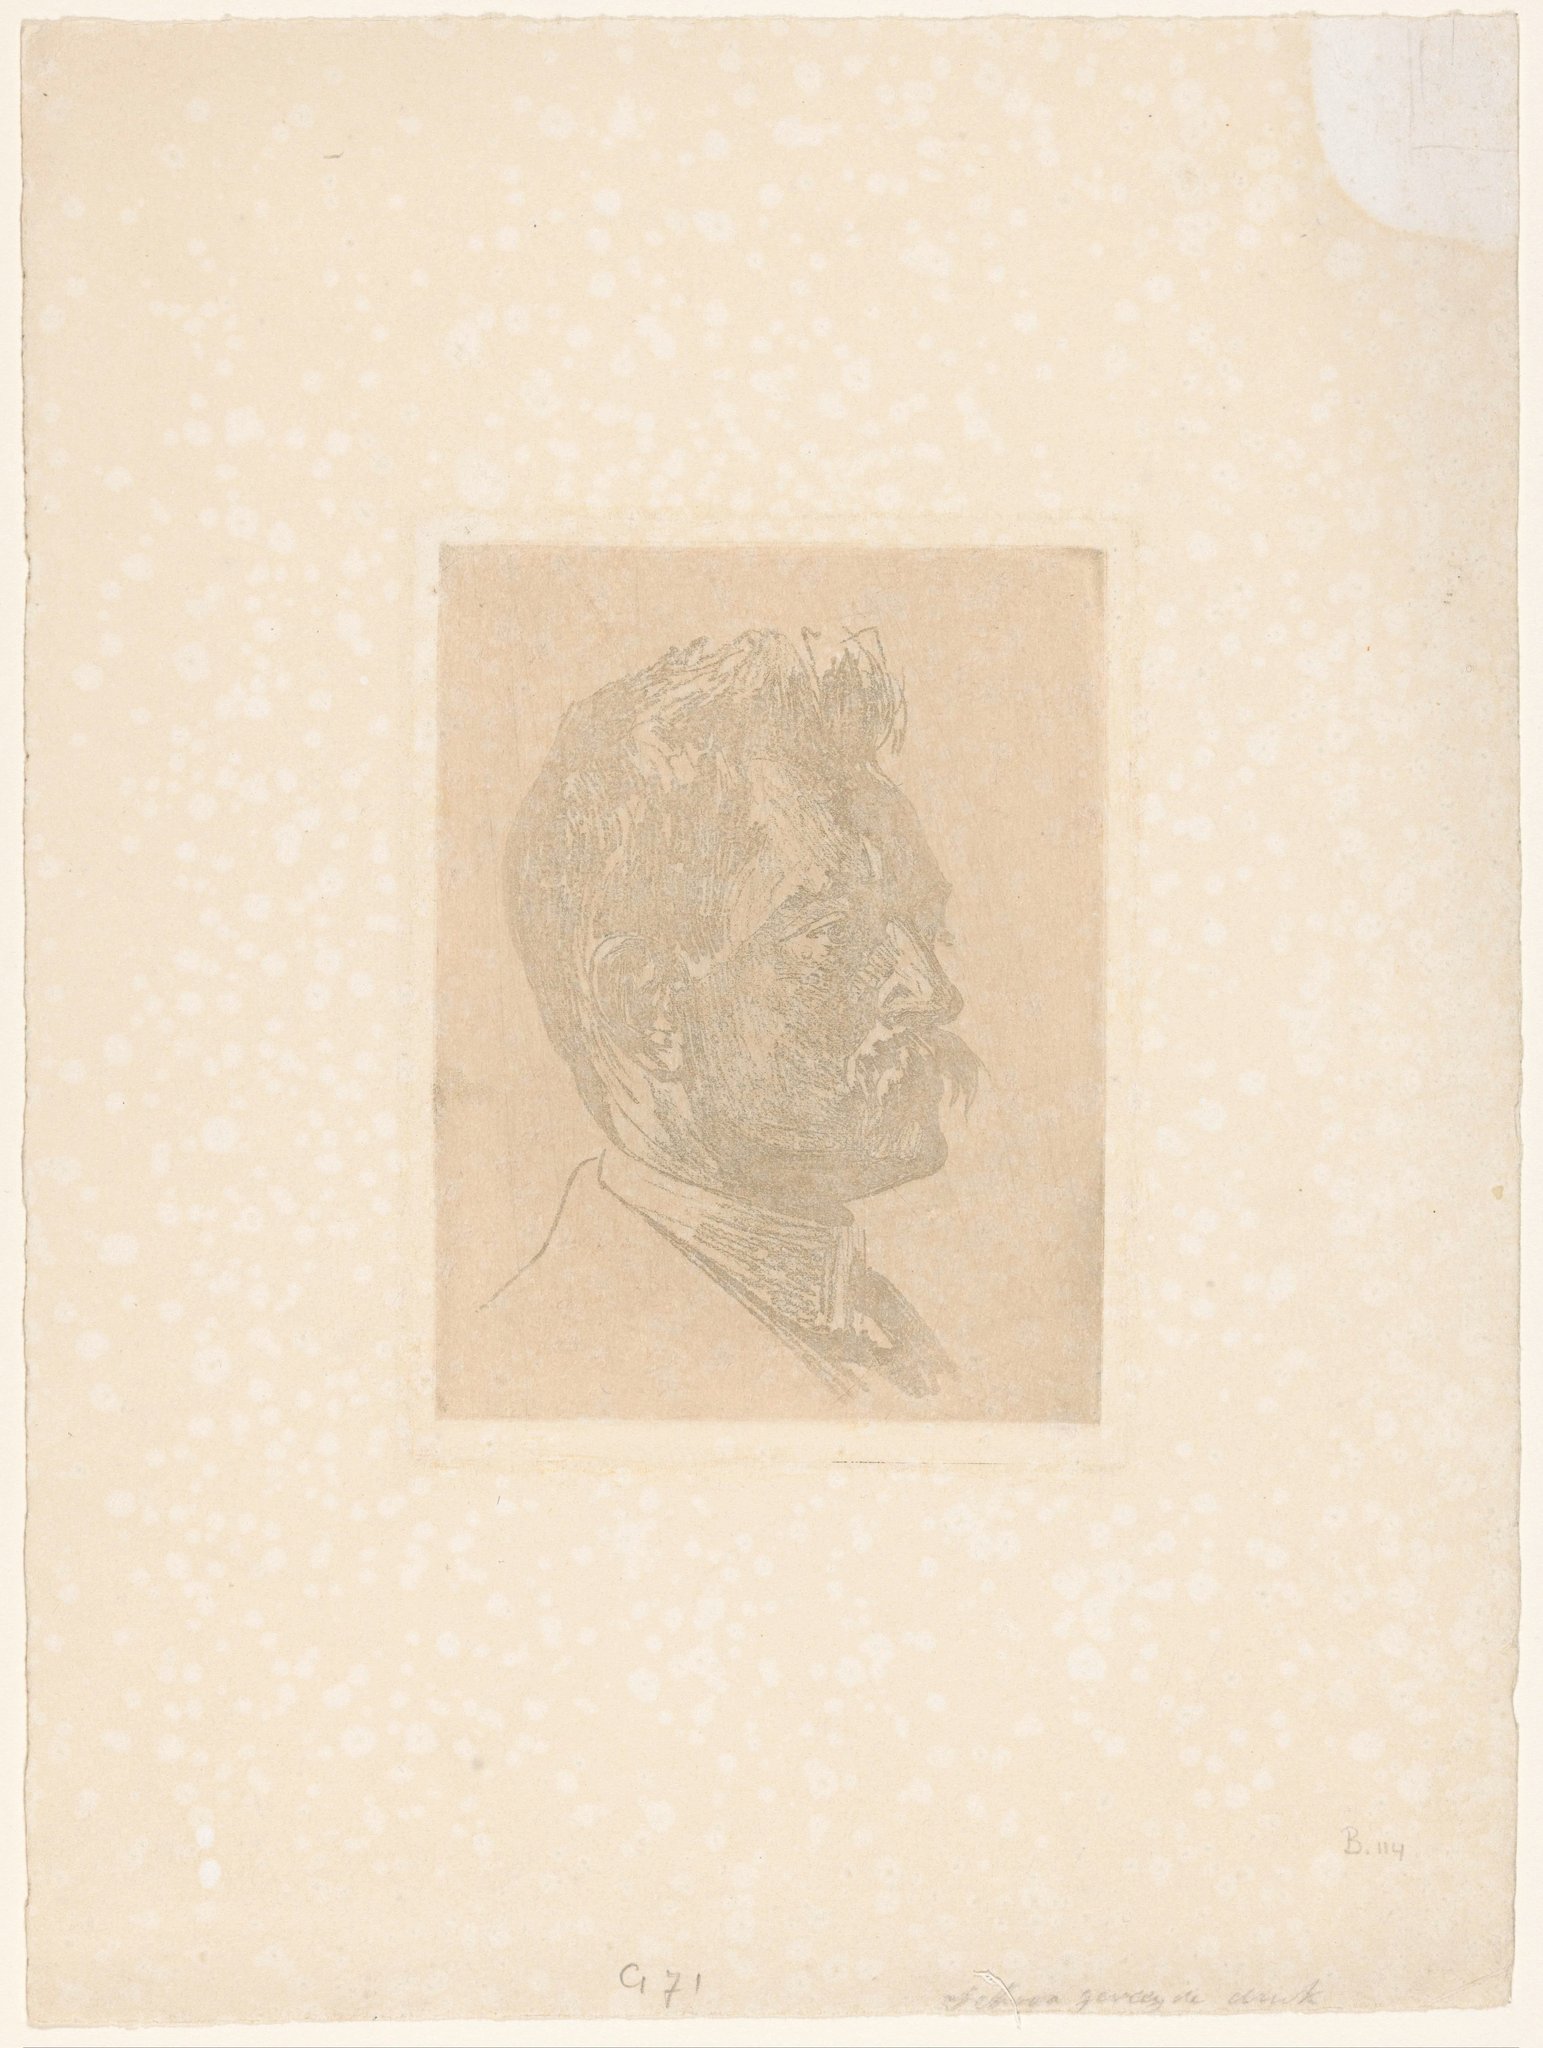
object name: print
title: Portret van Jan Hofker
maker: willem witsen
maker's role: draughtsman, painter, print maker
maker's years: 1860-1923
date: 1905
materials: paper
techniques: intaglio, soft ground etching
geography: amsterdam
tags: portrait of a writer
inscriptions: inscription: ‘schoongeveegde druk’